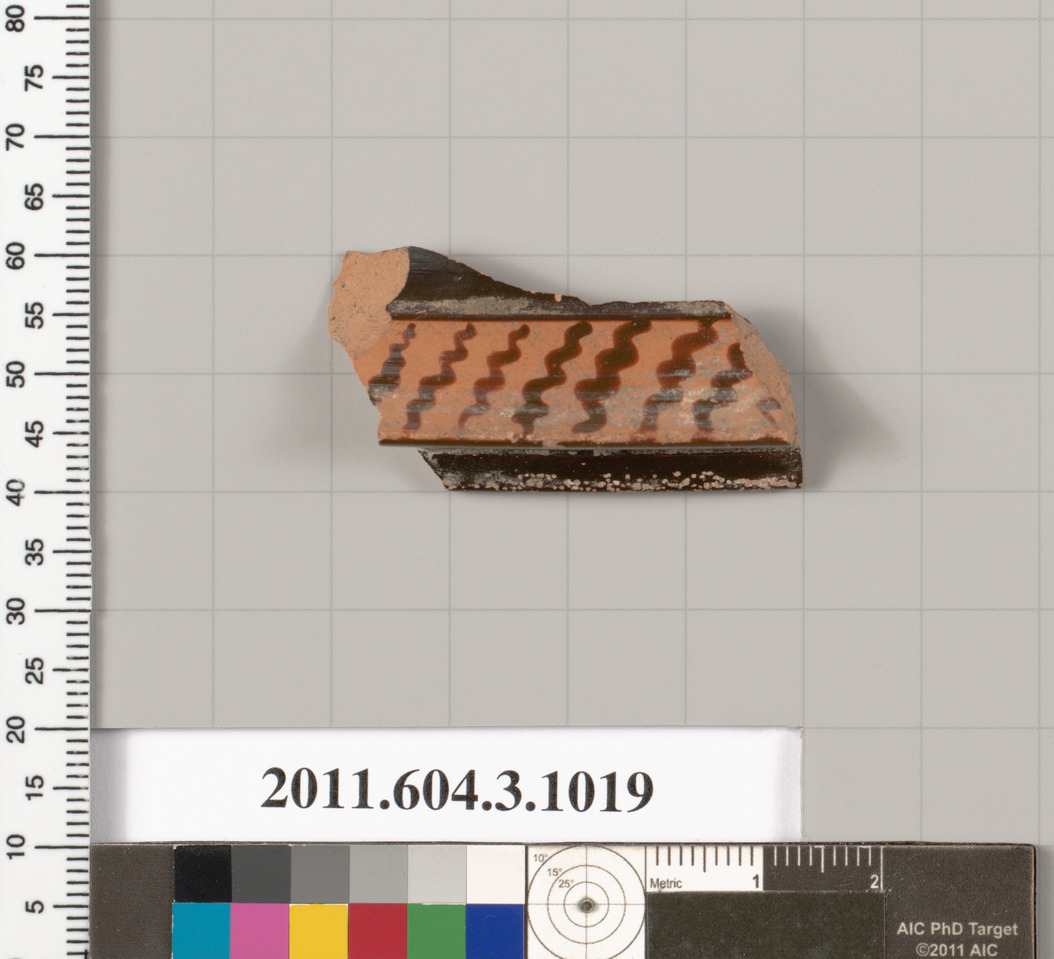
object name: lekanis fragment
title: Terracotta fragment of a lekanis (covered dish)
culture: greek, attic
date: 475-451 BCE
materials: terracotta